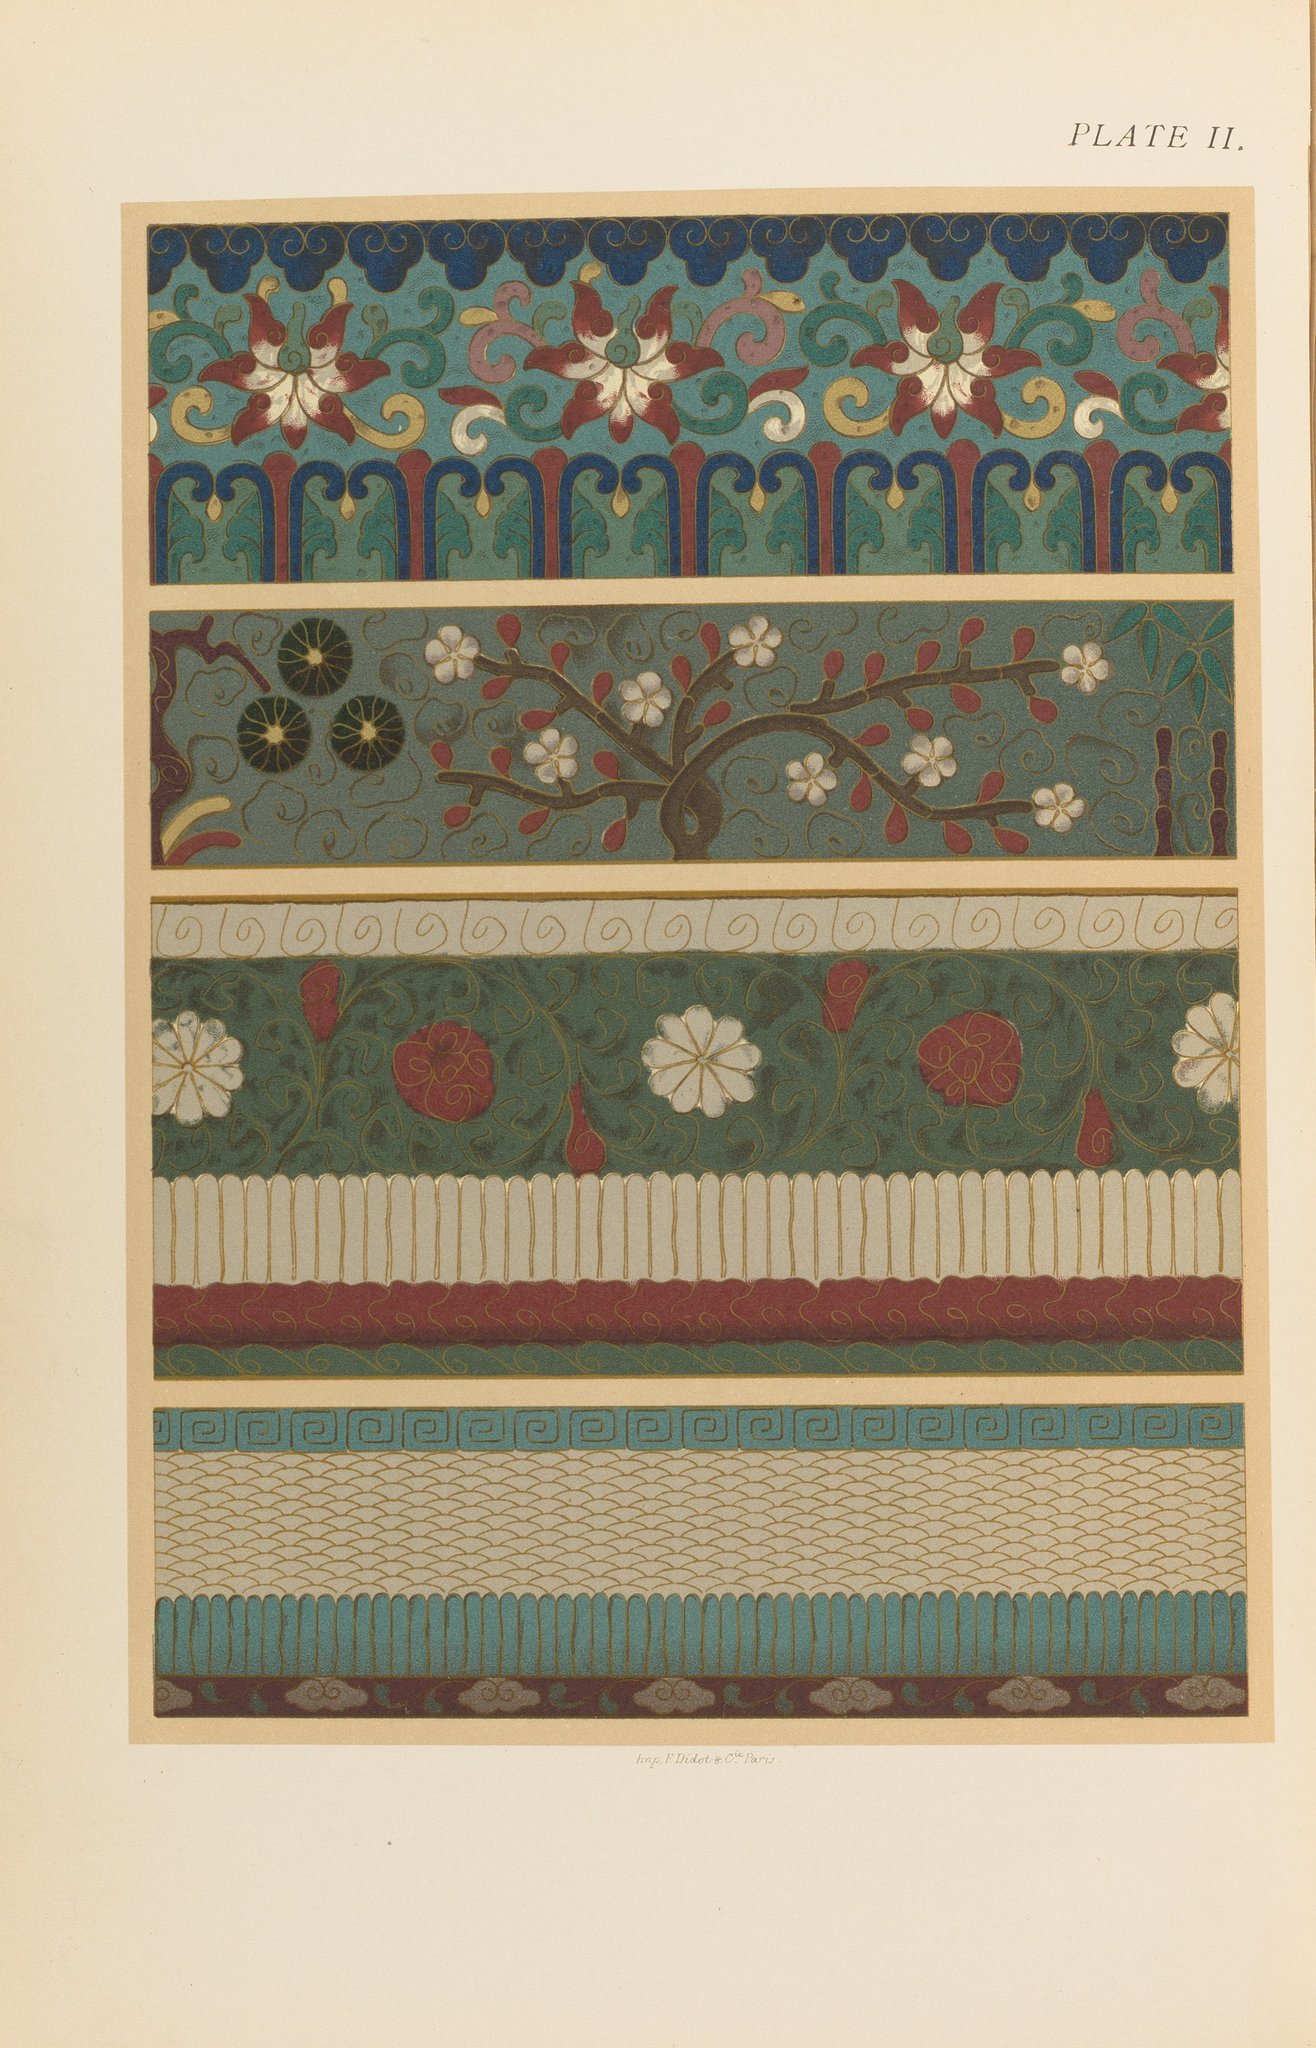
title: Japanese enamels, with illustrations from the examples in the Bowes collection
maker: james lord bowes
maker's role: author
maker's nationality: british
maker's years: 1834-1899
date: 1884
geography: england